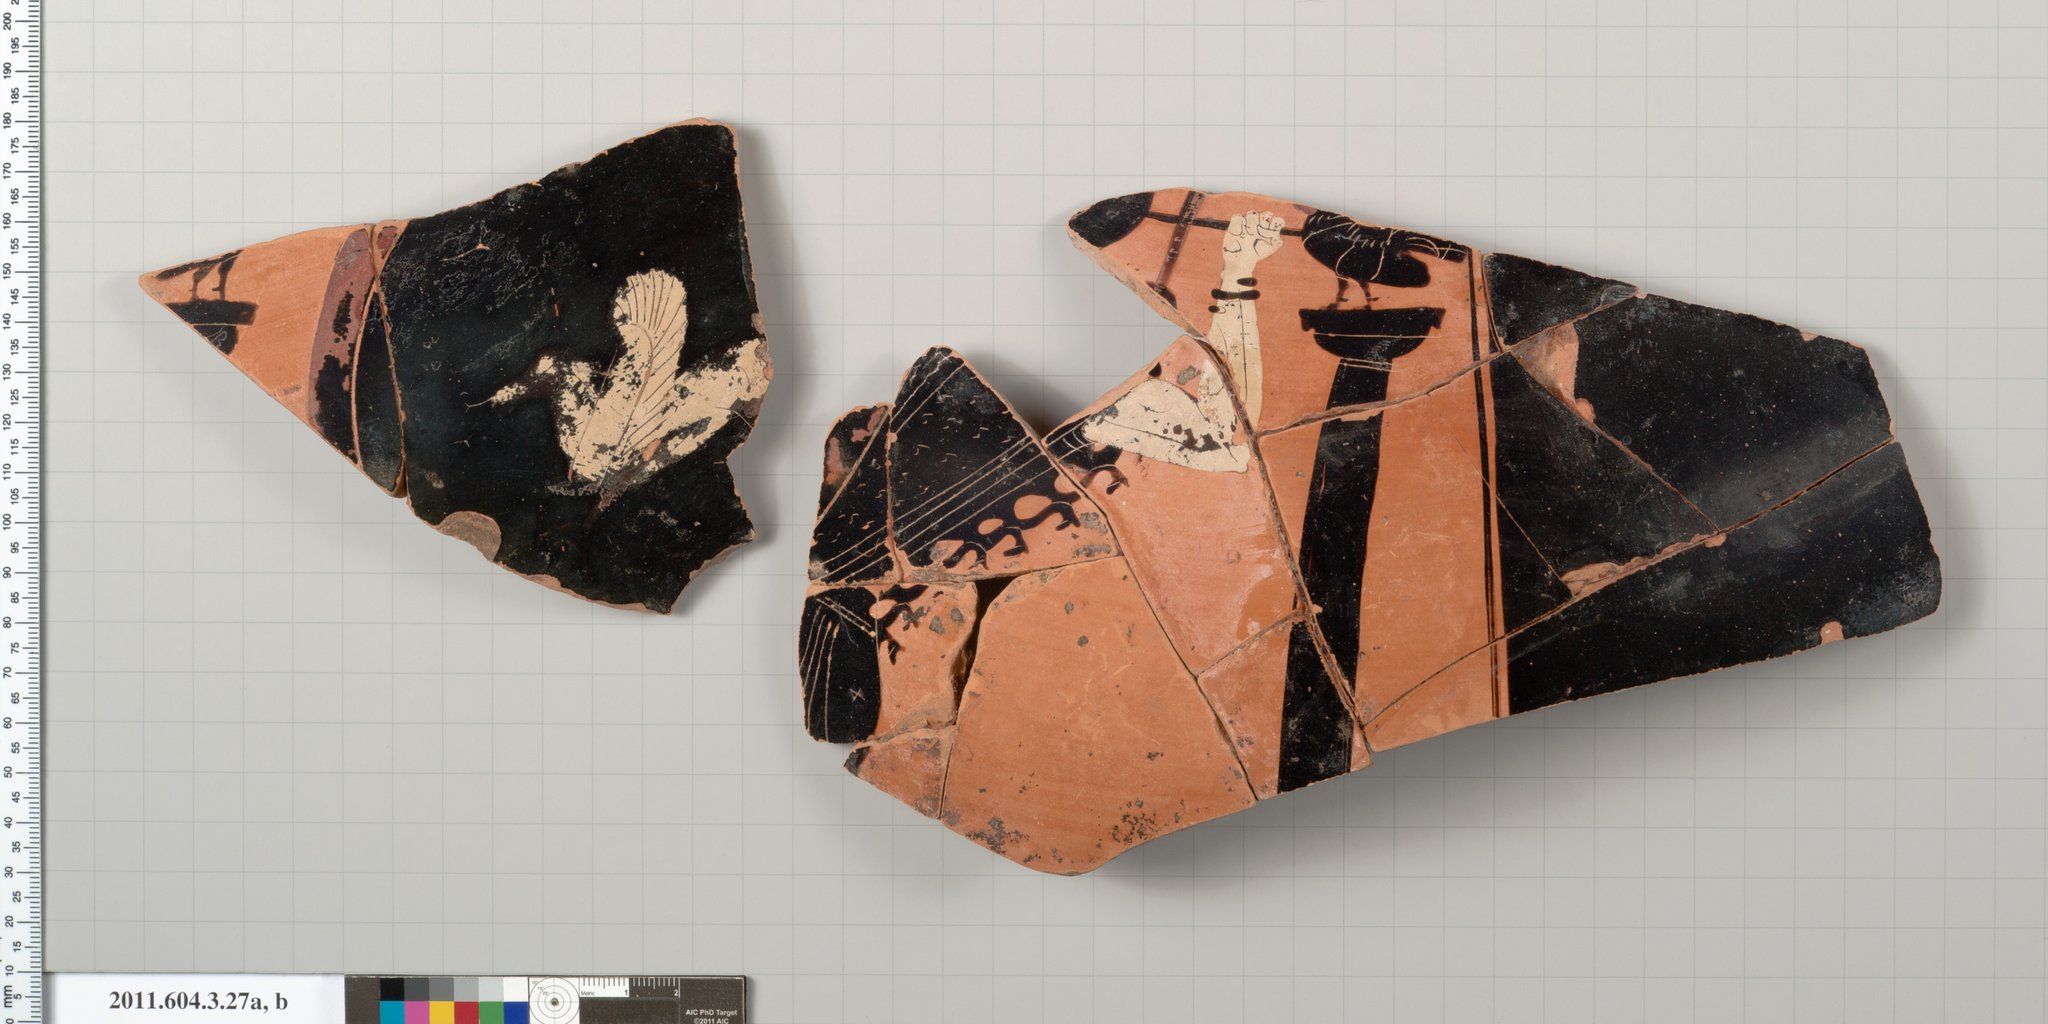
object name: panathenaic prize amphora fragment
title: Terracotta fragments of a Panathenaic prize amphora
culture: greek, attic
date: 500-476 BCE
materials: terracotta